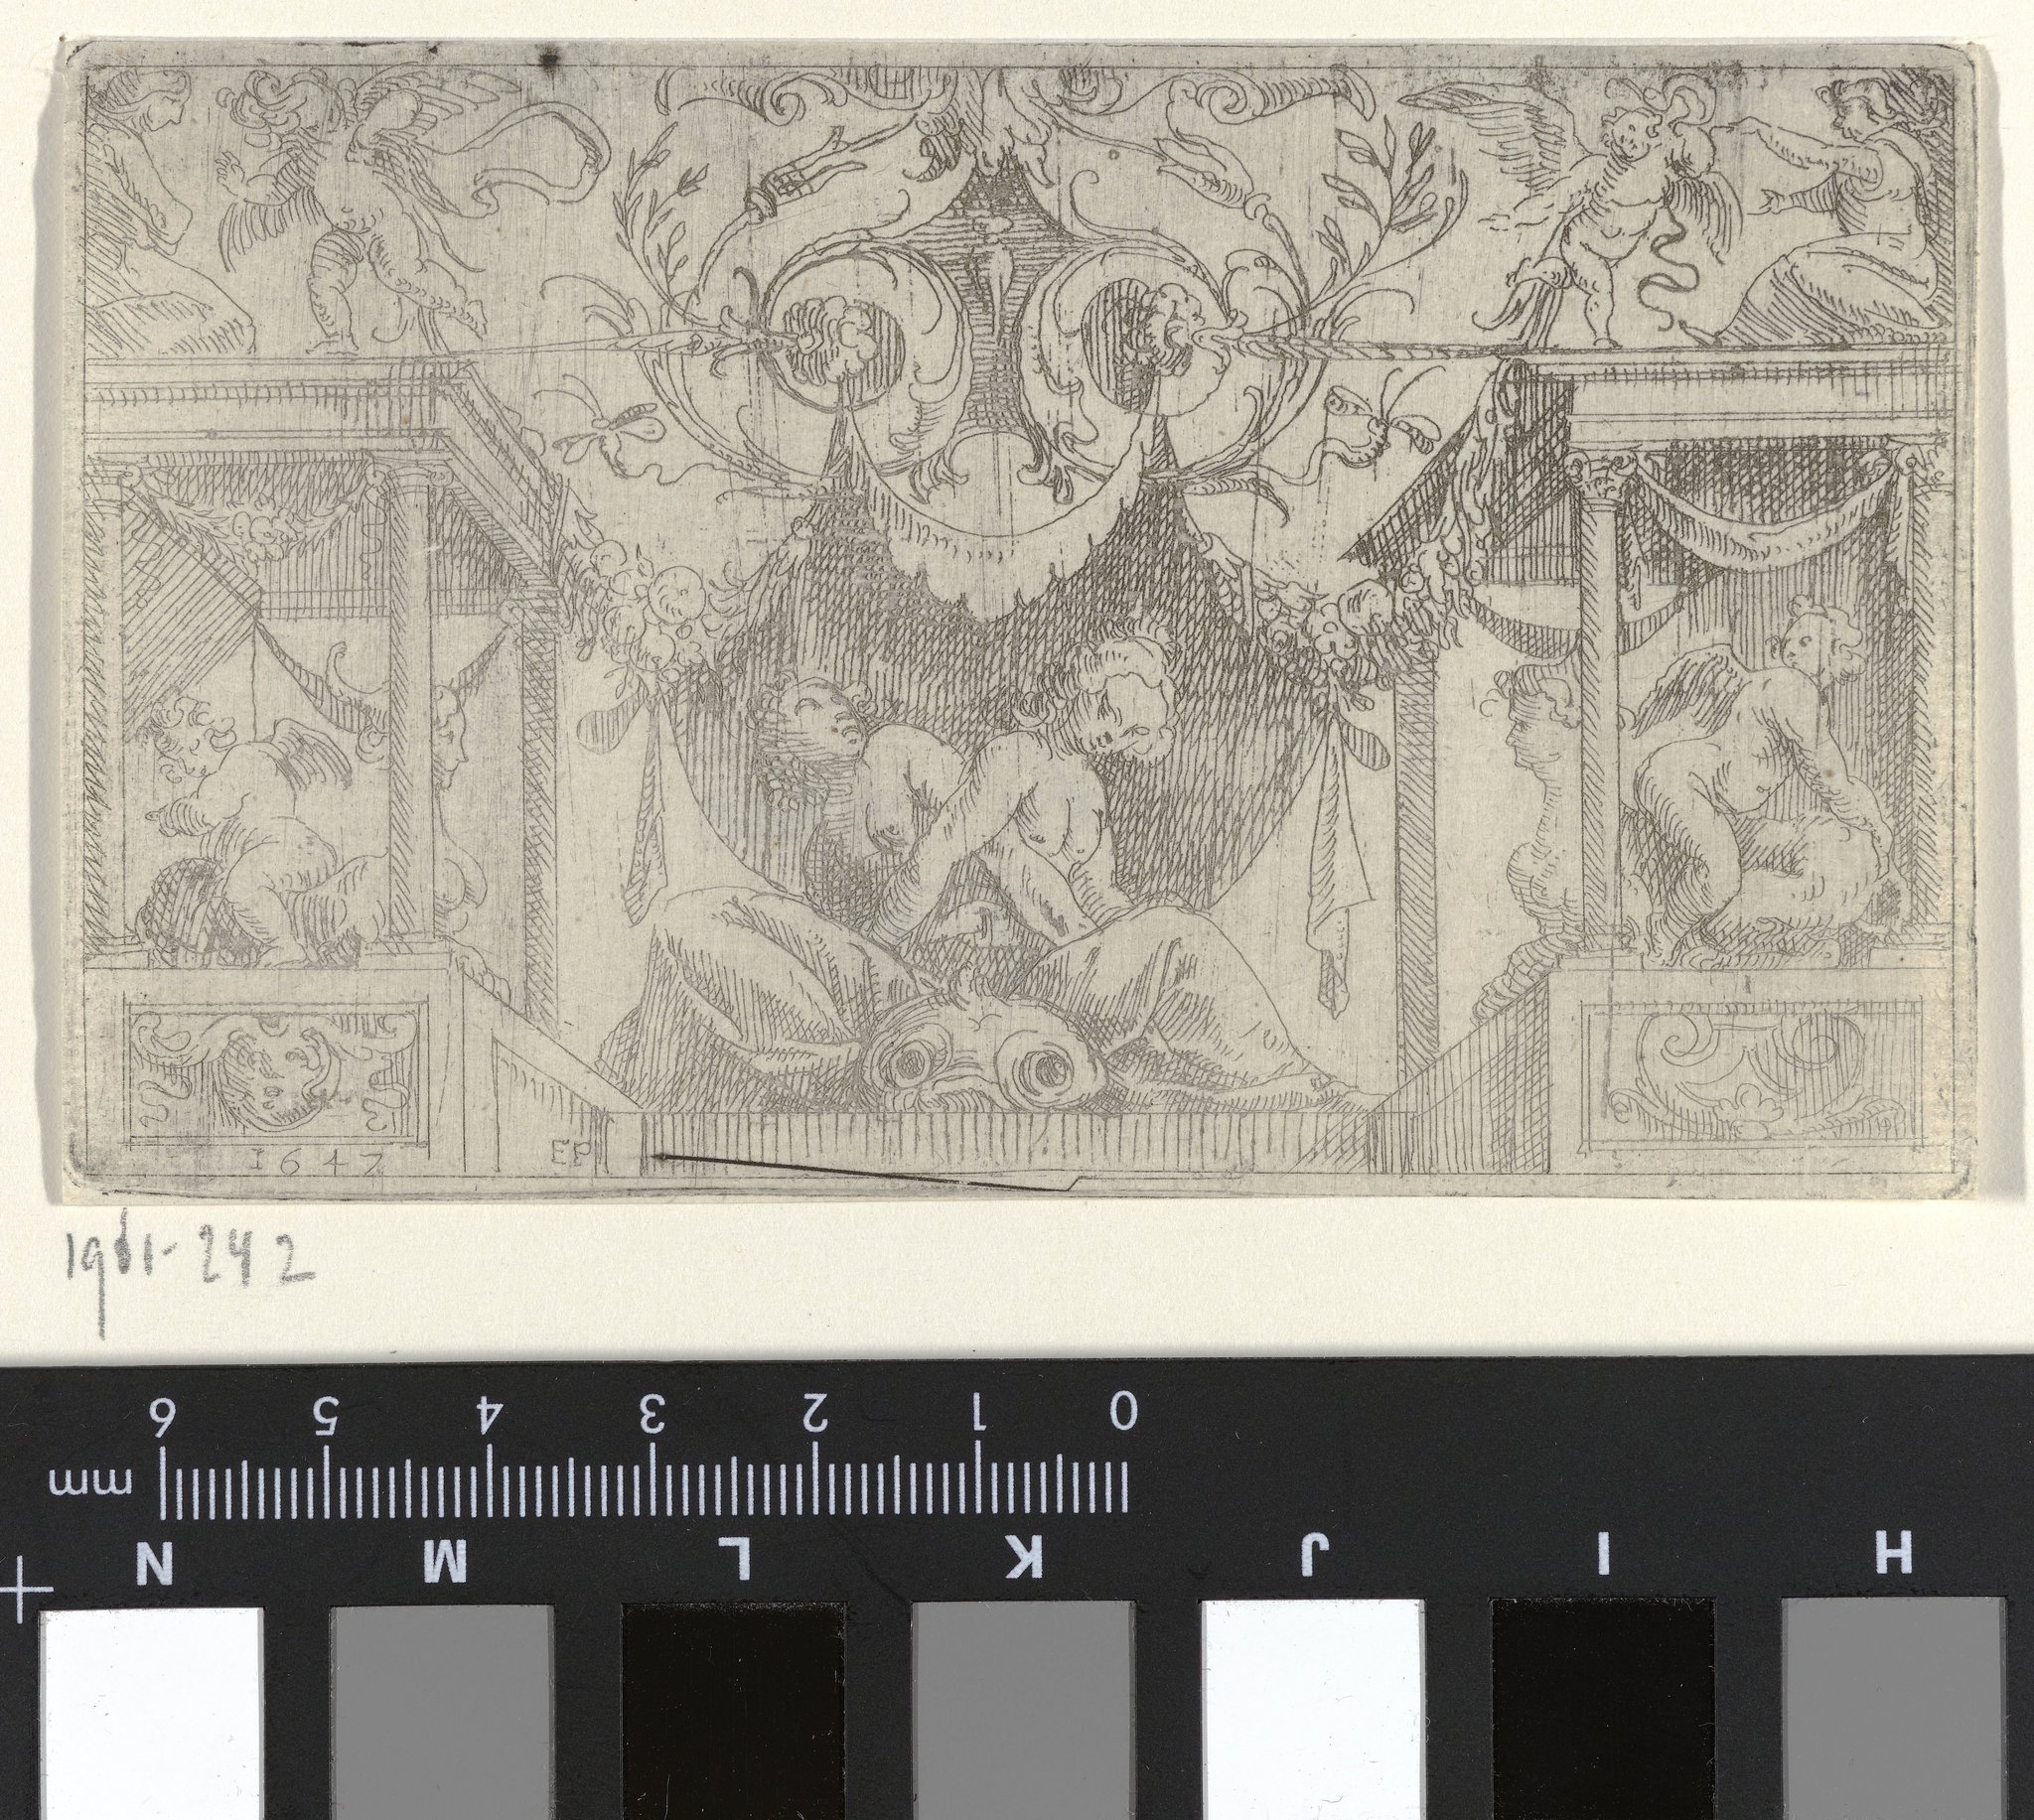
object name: print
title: Paneel met twee vrouwen en sfinxen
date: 1647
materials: paper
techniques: etching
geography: london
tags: ornament ~ grotesque, sitting figure - aa - female human figure, sphinx (lion/woman); 'sfinge' (ripa), cupids: 'amores', 'amoretti', 'putti'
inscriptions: collector's mark: Lugt 2228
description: Een paneel met grotesken. In het midden zitten twee vrouwen met de ruggen tegen elkaar op een dolfijn. Links en rechts een portico met zuilen waaronder putti op sfinxen zitten.